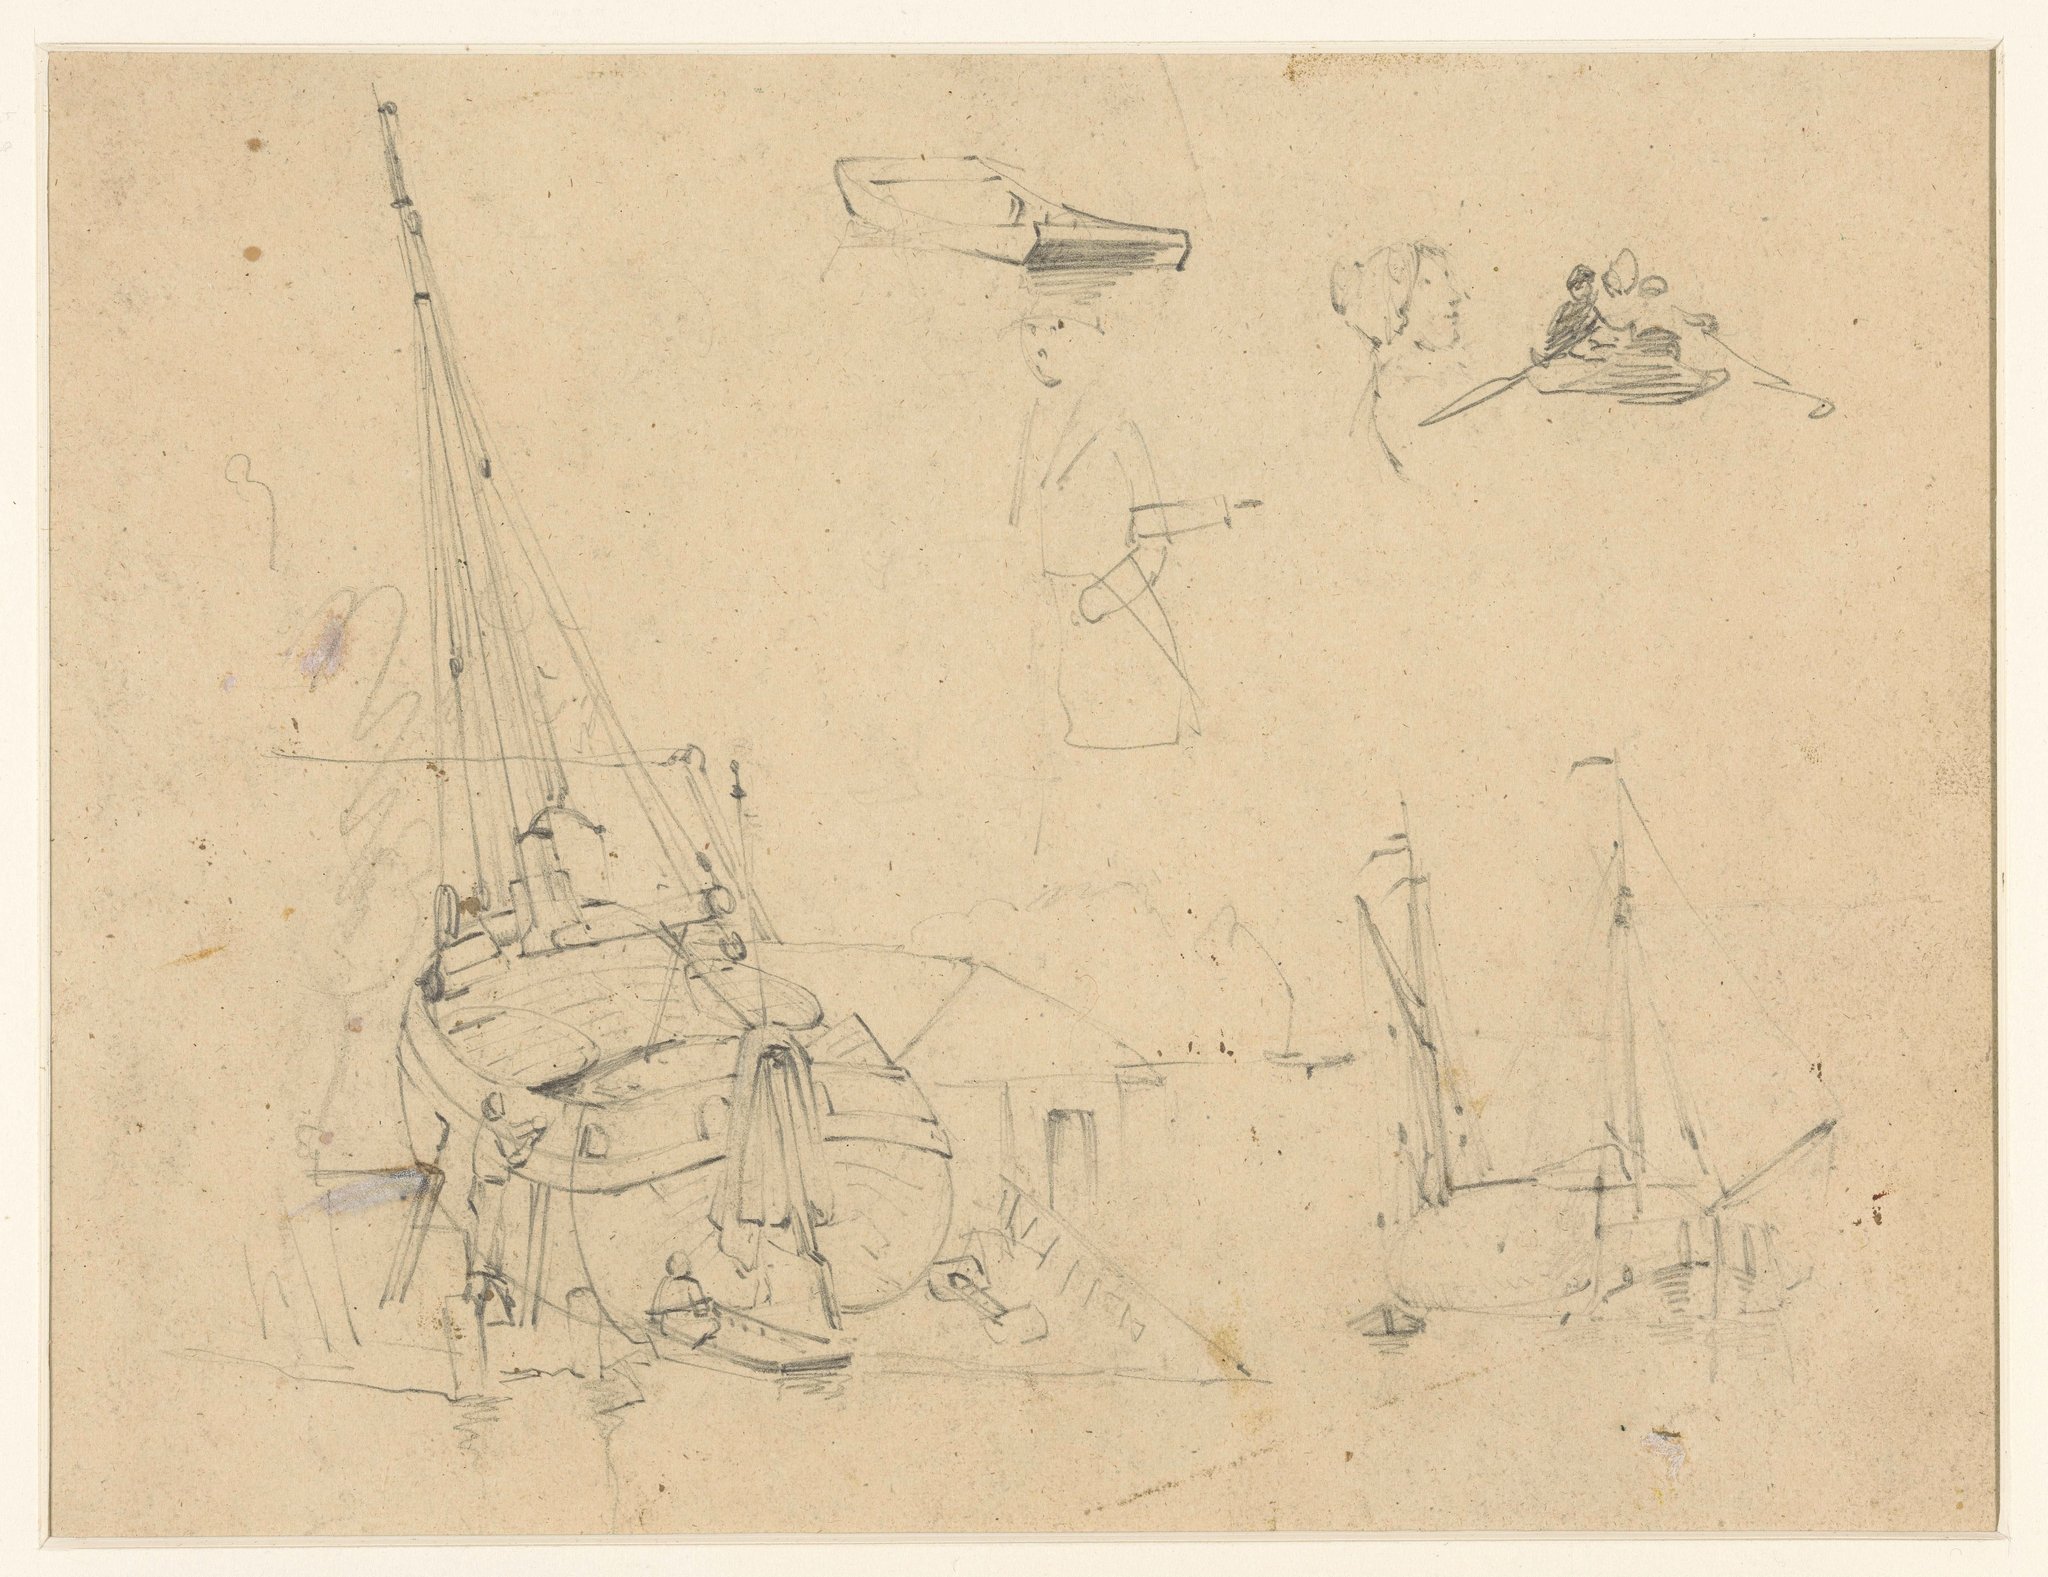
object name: drawing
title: Studies bij een scheepswerf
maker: jan weissenbruch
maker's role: painter, print maker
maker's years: 1822-1880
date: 1832-1880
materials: paper, pencil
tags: sailing-ship, sailing-boat, dry-dock, floating-dock